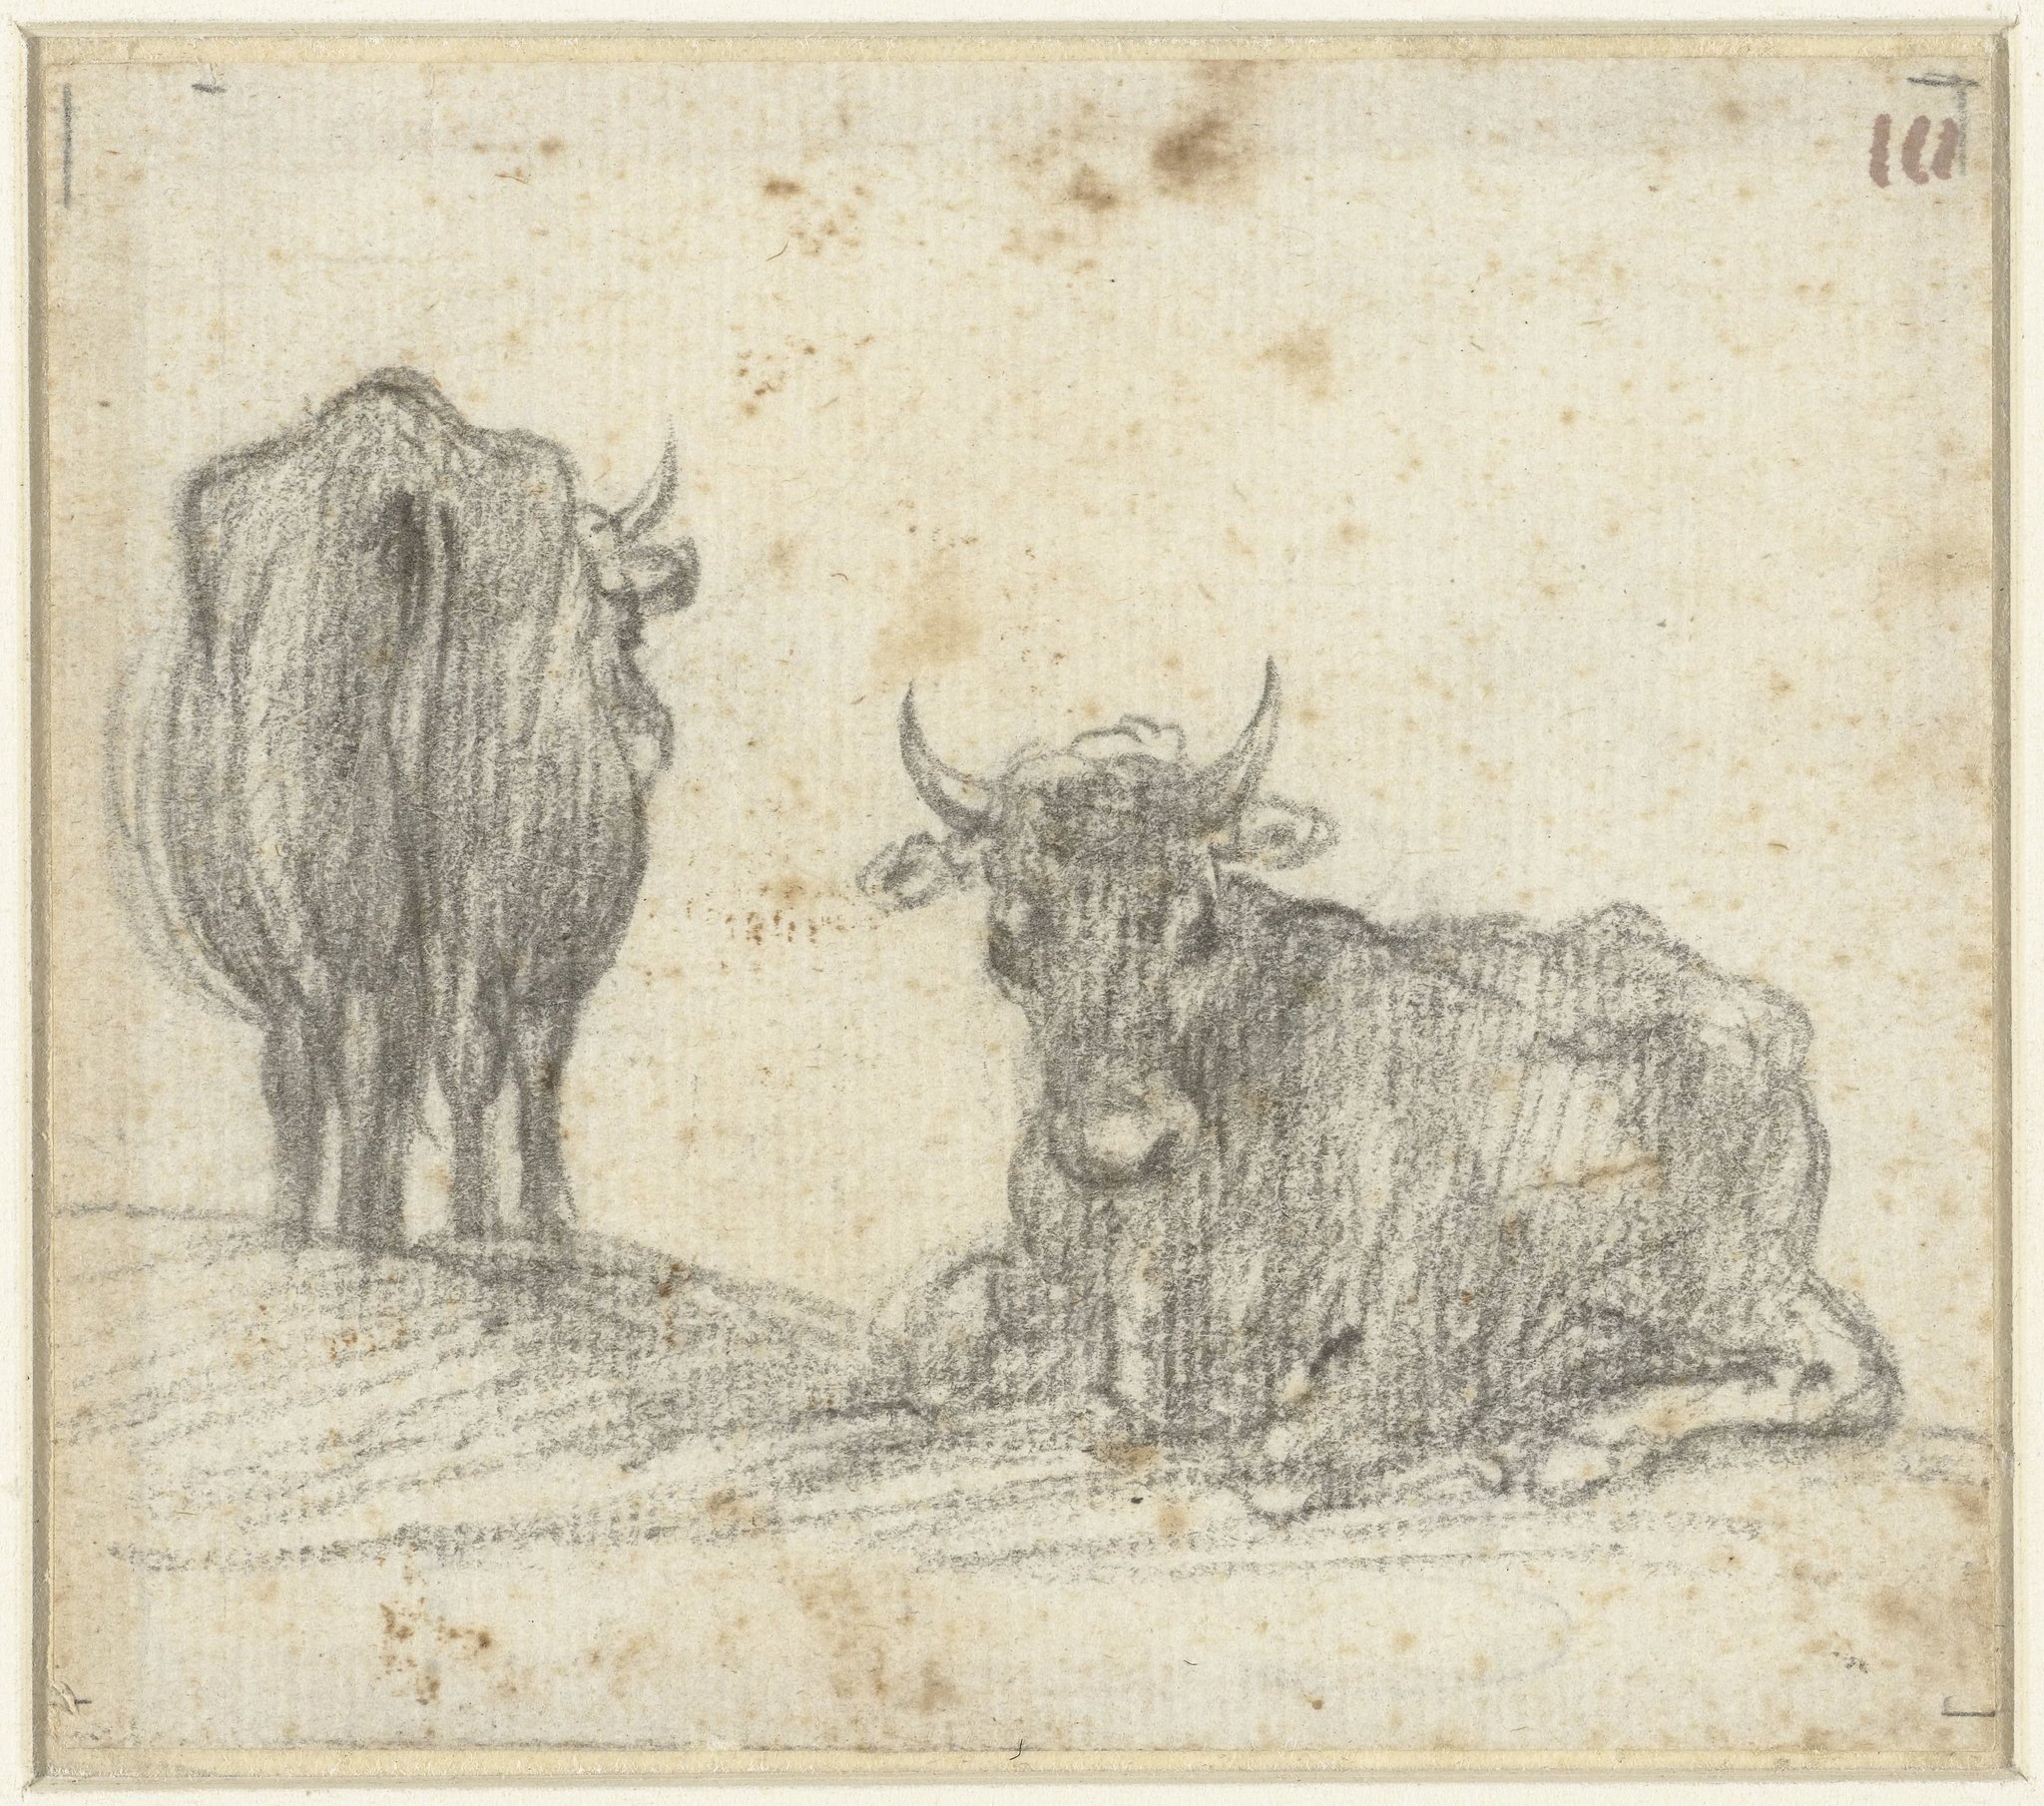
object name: drawing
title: Studies van vee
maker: claude lorrain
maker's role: draughtsman, print maker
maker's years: 1604-1682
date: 1635-1645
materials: chalk, paper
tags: bovine cattle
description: Bladen van serie zijn afkomstig uit een schetsboek.